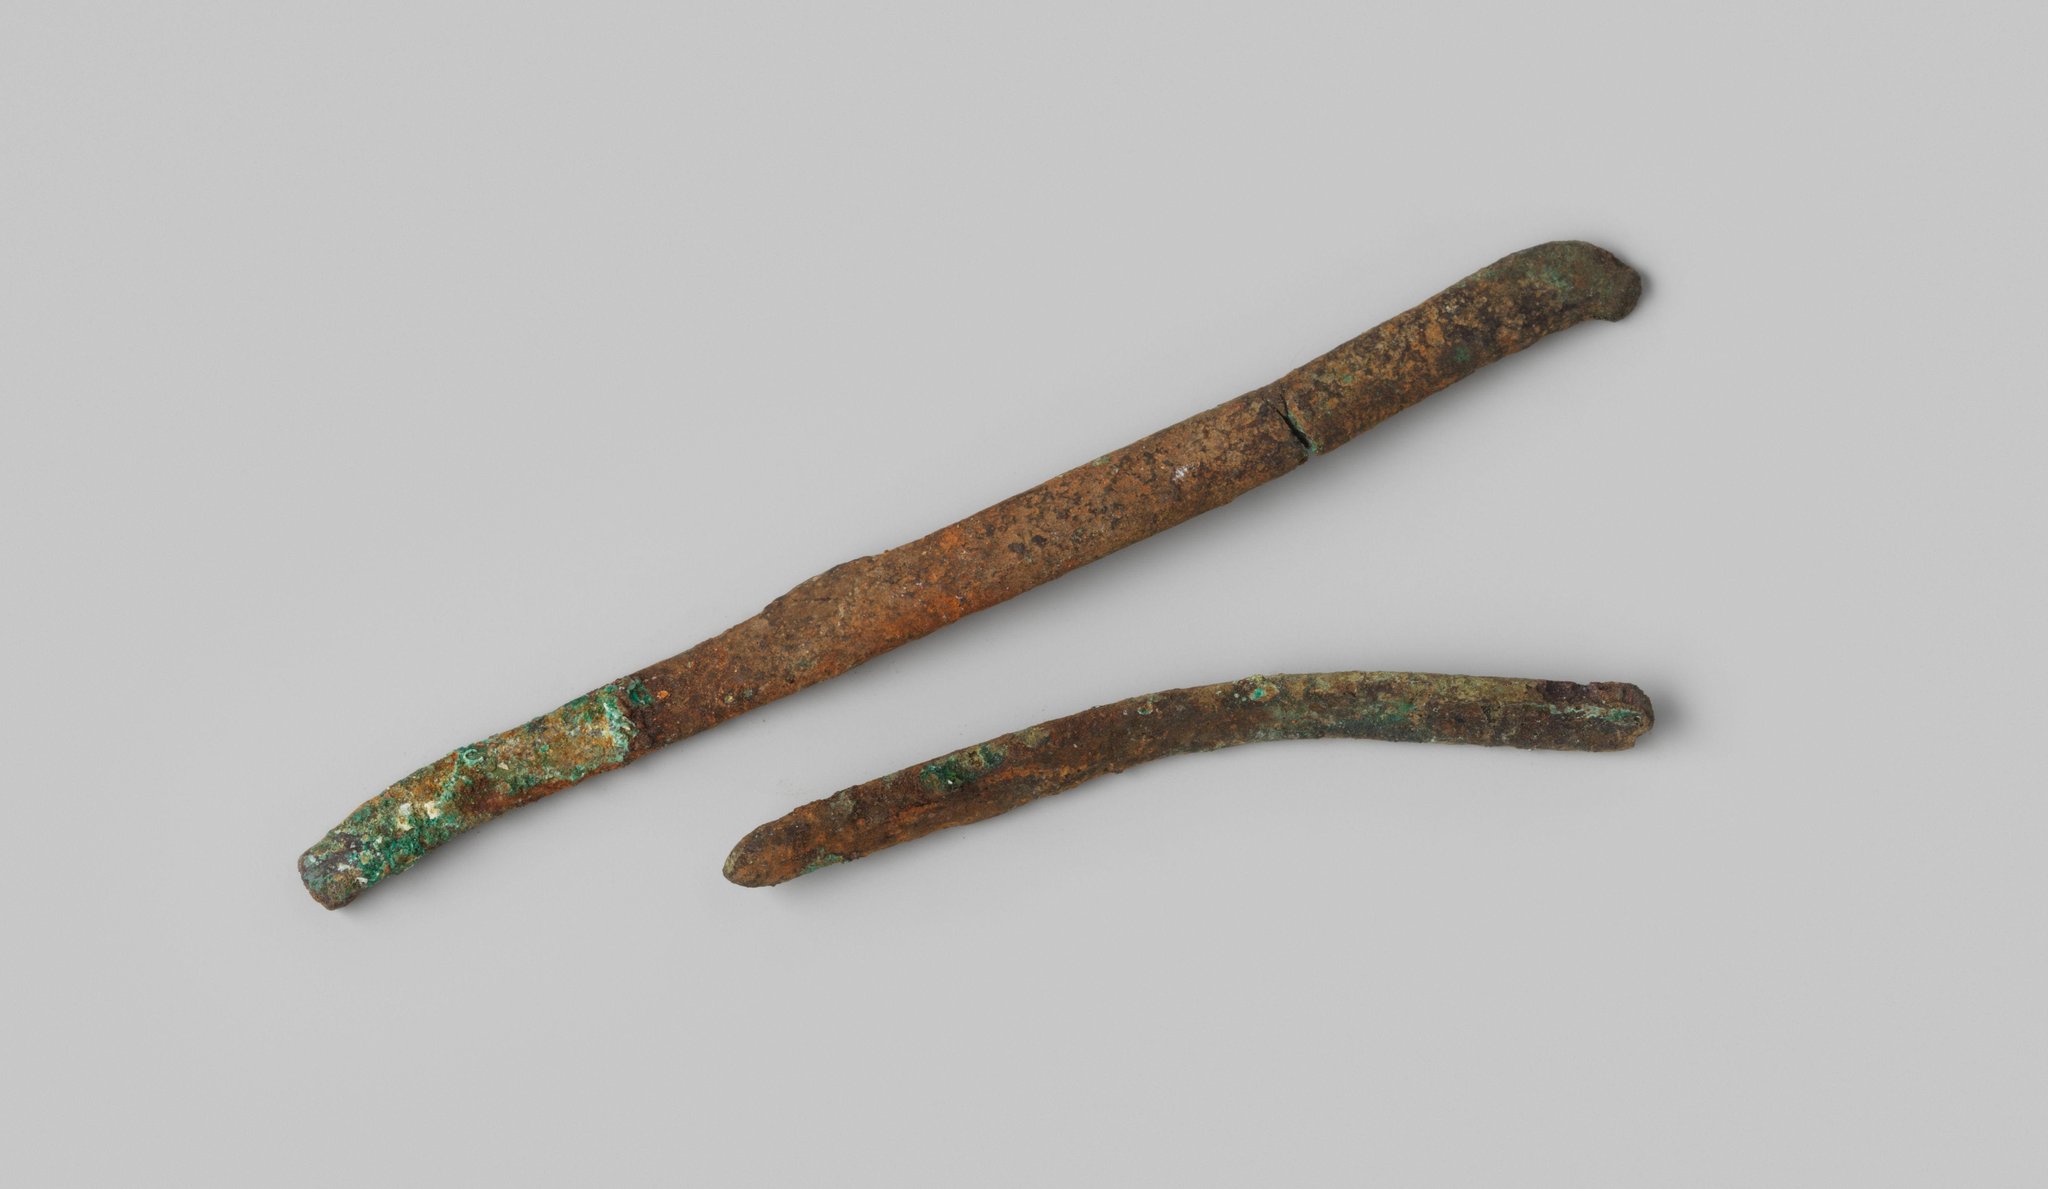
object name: belt buckle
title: Fragmenten riemgesp uit het wrak van de Oost-Indiëvaarder Hollandia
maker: Anonymous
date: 1700-1743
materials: copper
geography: netherlands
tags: verenigde oostindische compagnie, hollandia (schip), annet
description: Rectangular, fragm of rings with spindle, id. NG 1980-27H2852, belt buckle.